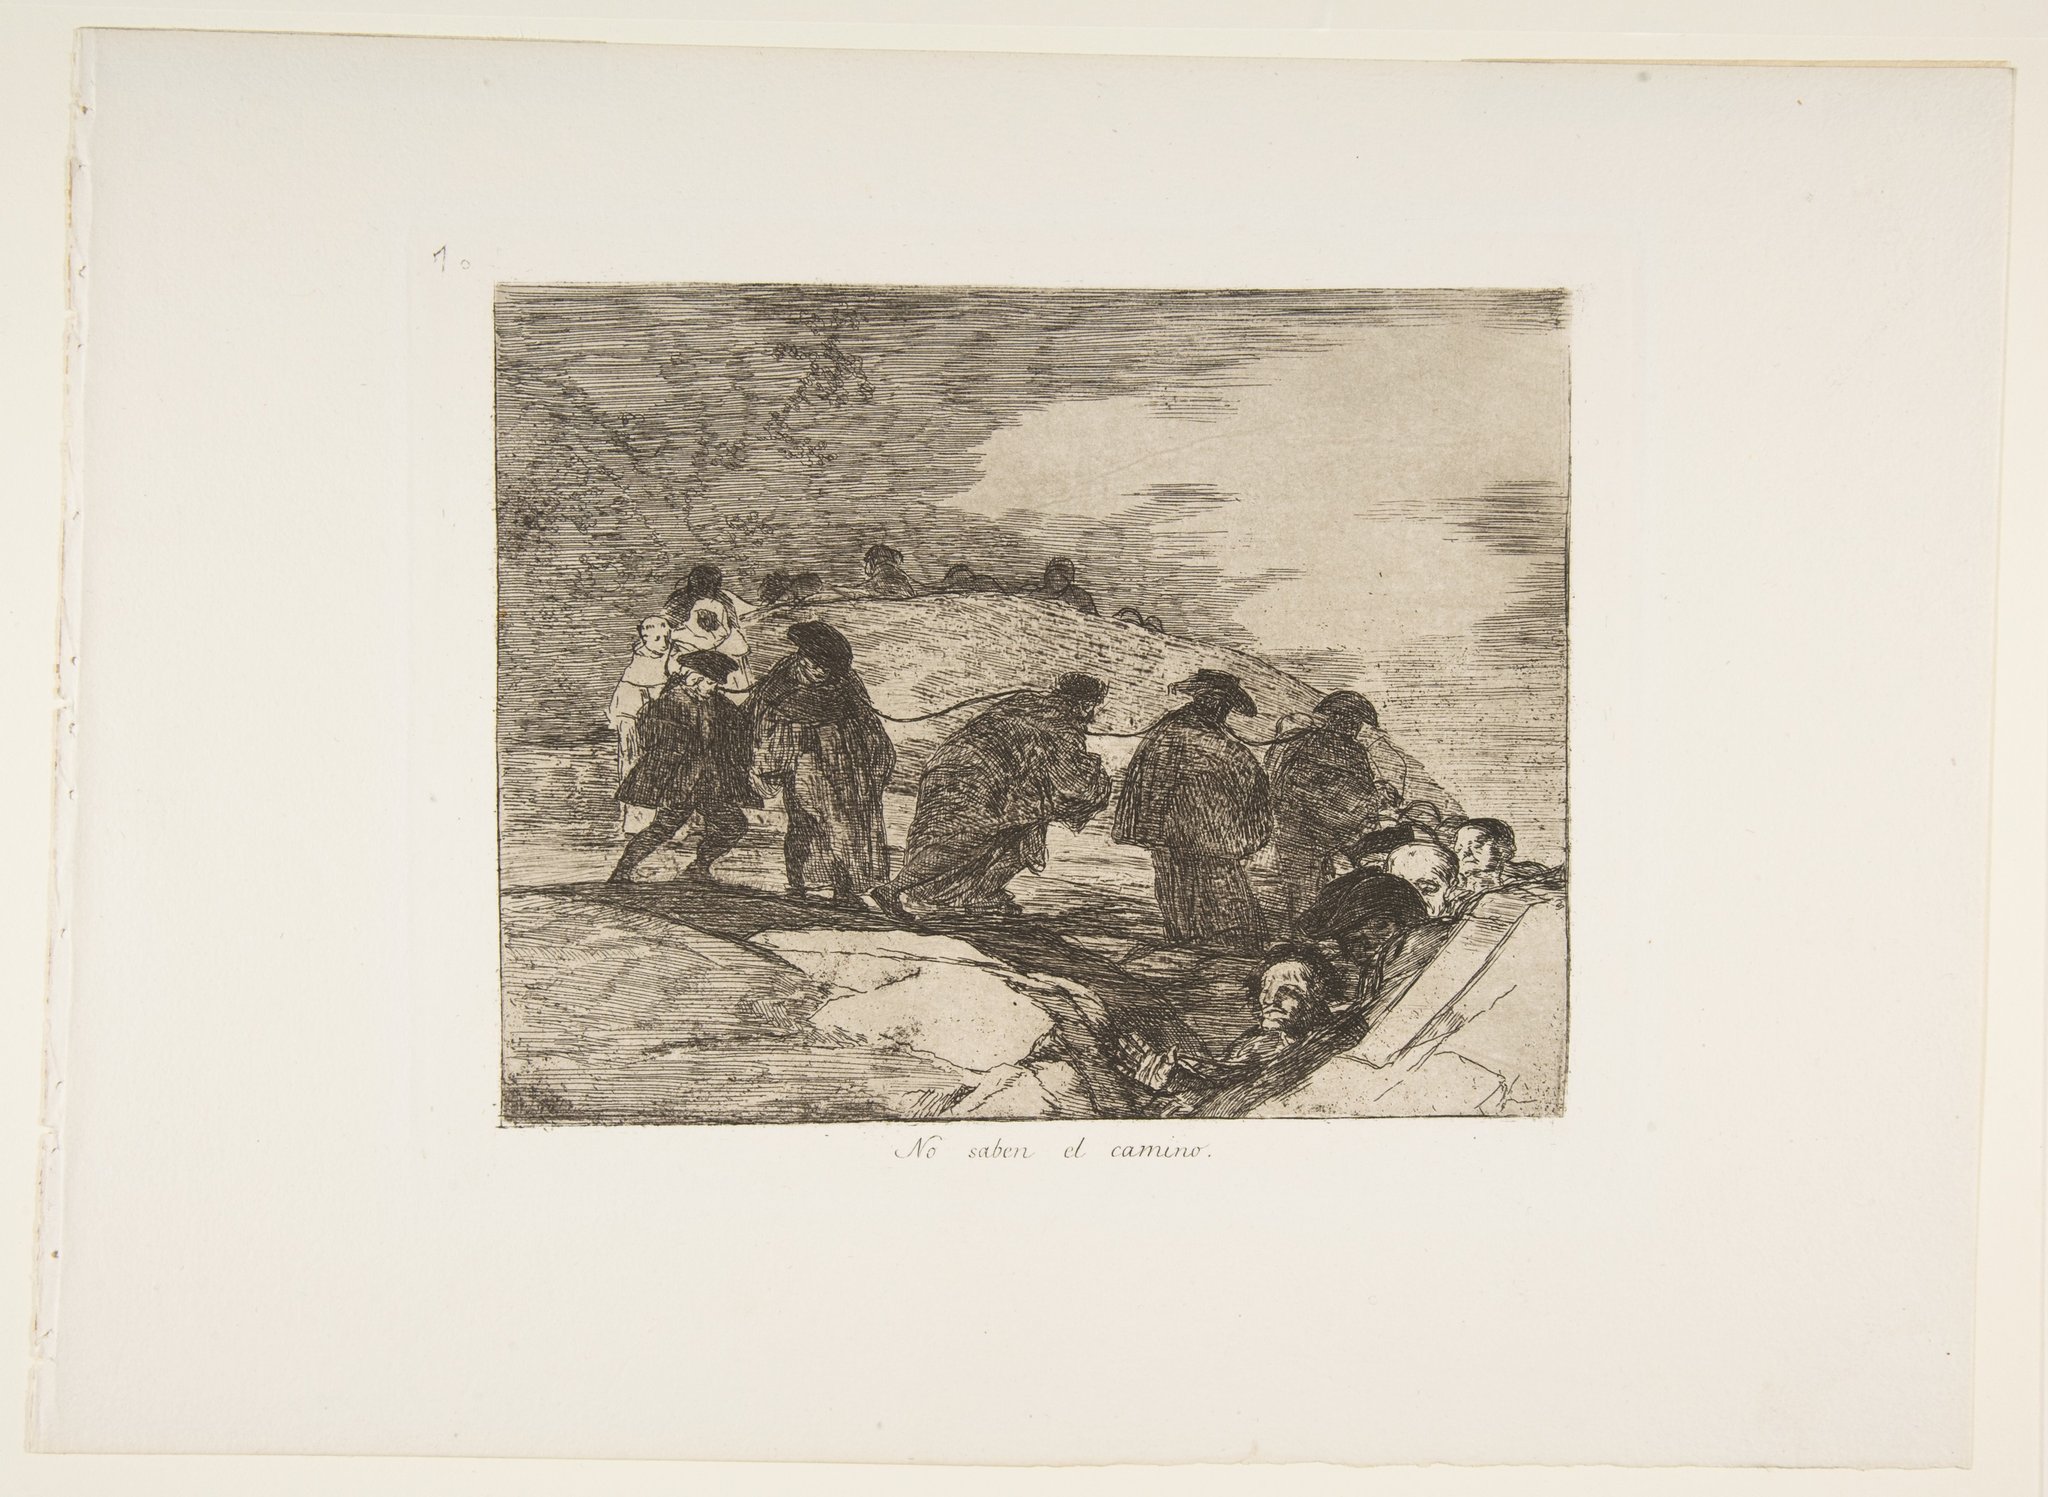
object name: print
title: Plate 70 from "The Disasters of War" (Los Desastres de la Guerra): 'They do not know the way' (No saben el camino)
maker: goya (francisco de goya y lucientes)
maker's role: artist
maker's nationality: spanish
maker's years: 1746-1828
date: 1814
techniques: engraving, drypoint, etching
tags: human figures